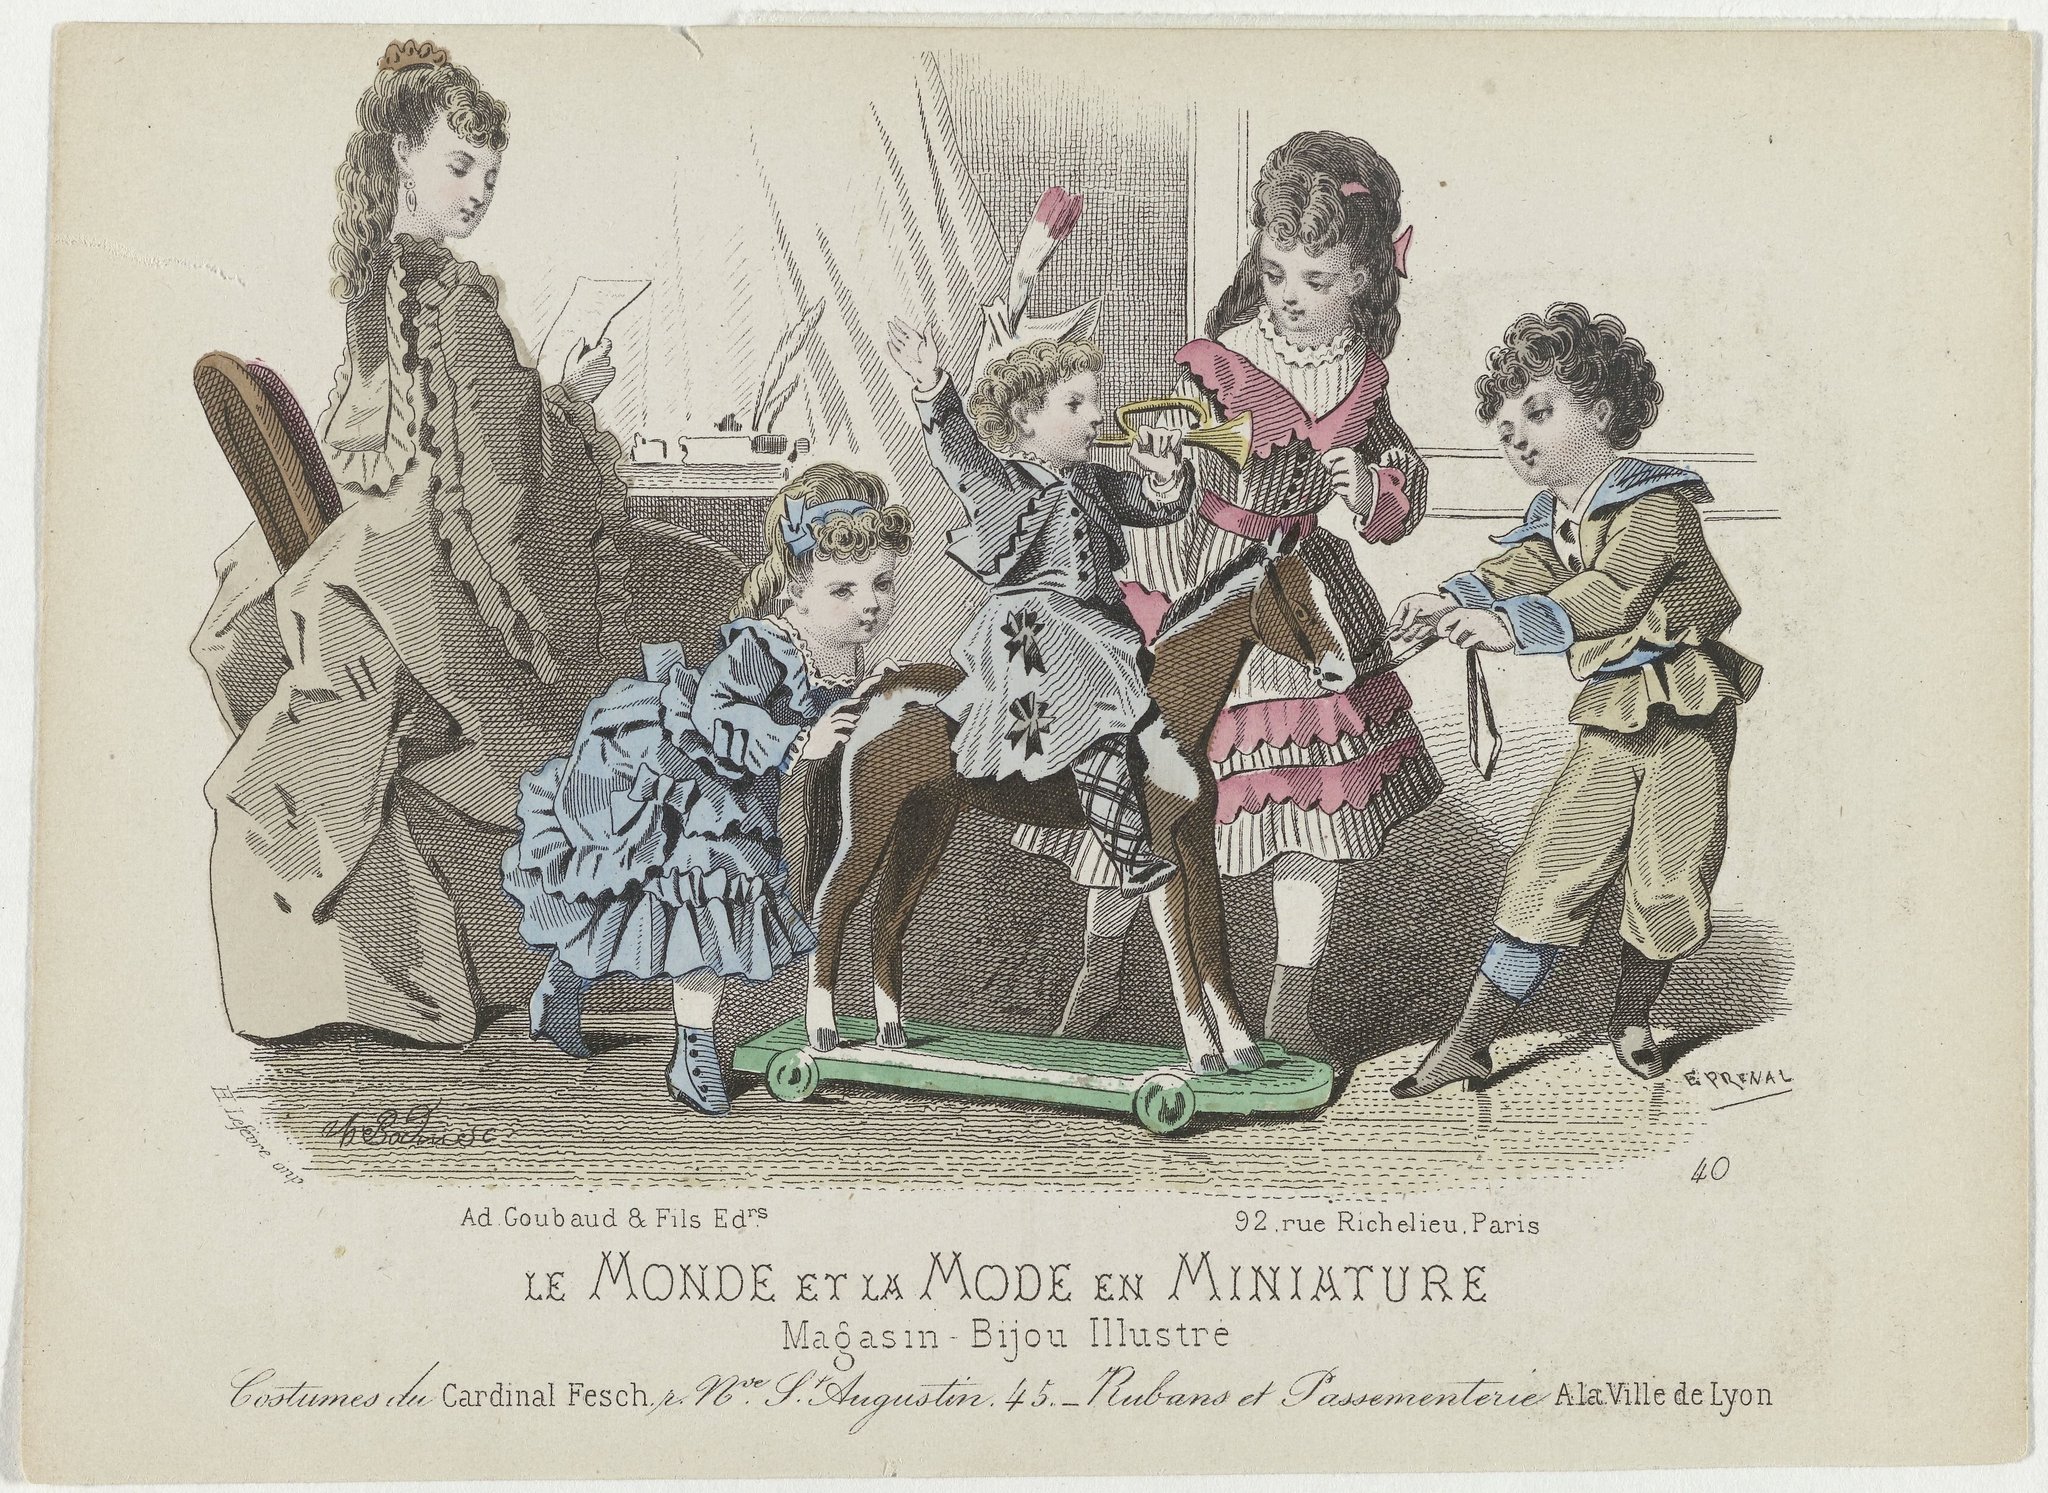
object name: fashion print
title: Le Monde et la Mode en Miniature, 1873, No. 40 : Costumes du Cardinal Fesch (...)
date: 1873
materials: paper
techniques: engraving, hand coloring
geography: paris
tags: boots (+ boys' clothes), trousers, breeches (+ boys' clothes), stockings, socks (+ girls' clothes), head-gear (+ girls' clothes), clothing for the upper part of the body (+ boys' clothes), boots (+ girls' clothes), sailor (+ variant), horn, trumpet, cornet, trombone, tuba, coat (+ girls' clothes), comb, brush and other tools (care of the hair) - aa - ~ women, fashion plates, letter, envelope, dress, gown (+ girls' clothes)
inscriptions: caption: ‘Costumes du Cardinal Fesch,r. Nve St Augustin 45_ Rubans et Passementerie A la Ville de Lyon’, title: ‘Le Monde et la Mode en Miniature / Magasin - Bijou Illustré’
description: Een vrouw en vier kinderen in interieur, de jongen is gekleed in een matrozenpakje, de meisjes dragen japonnen met tournure. Volgens het onderschrift is de kleding van Cardinal Fesch en het passement van Ville de Lyon. Prent uit het modetijdschrift Le Monde et la Mode en Miniature (1873-1874).